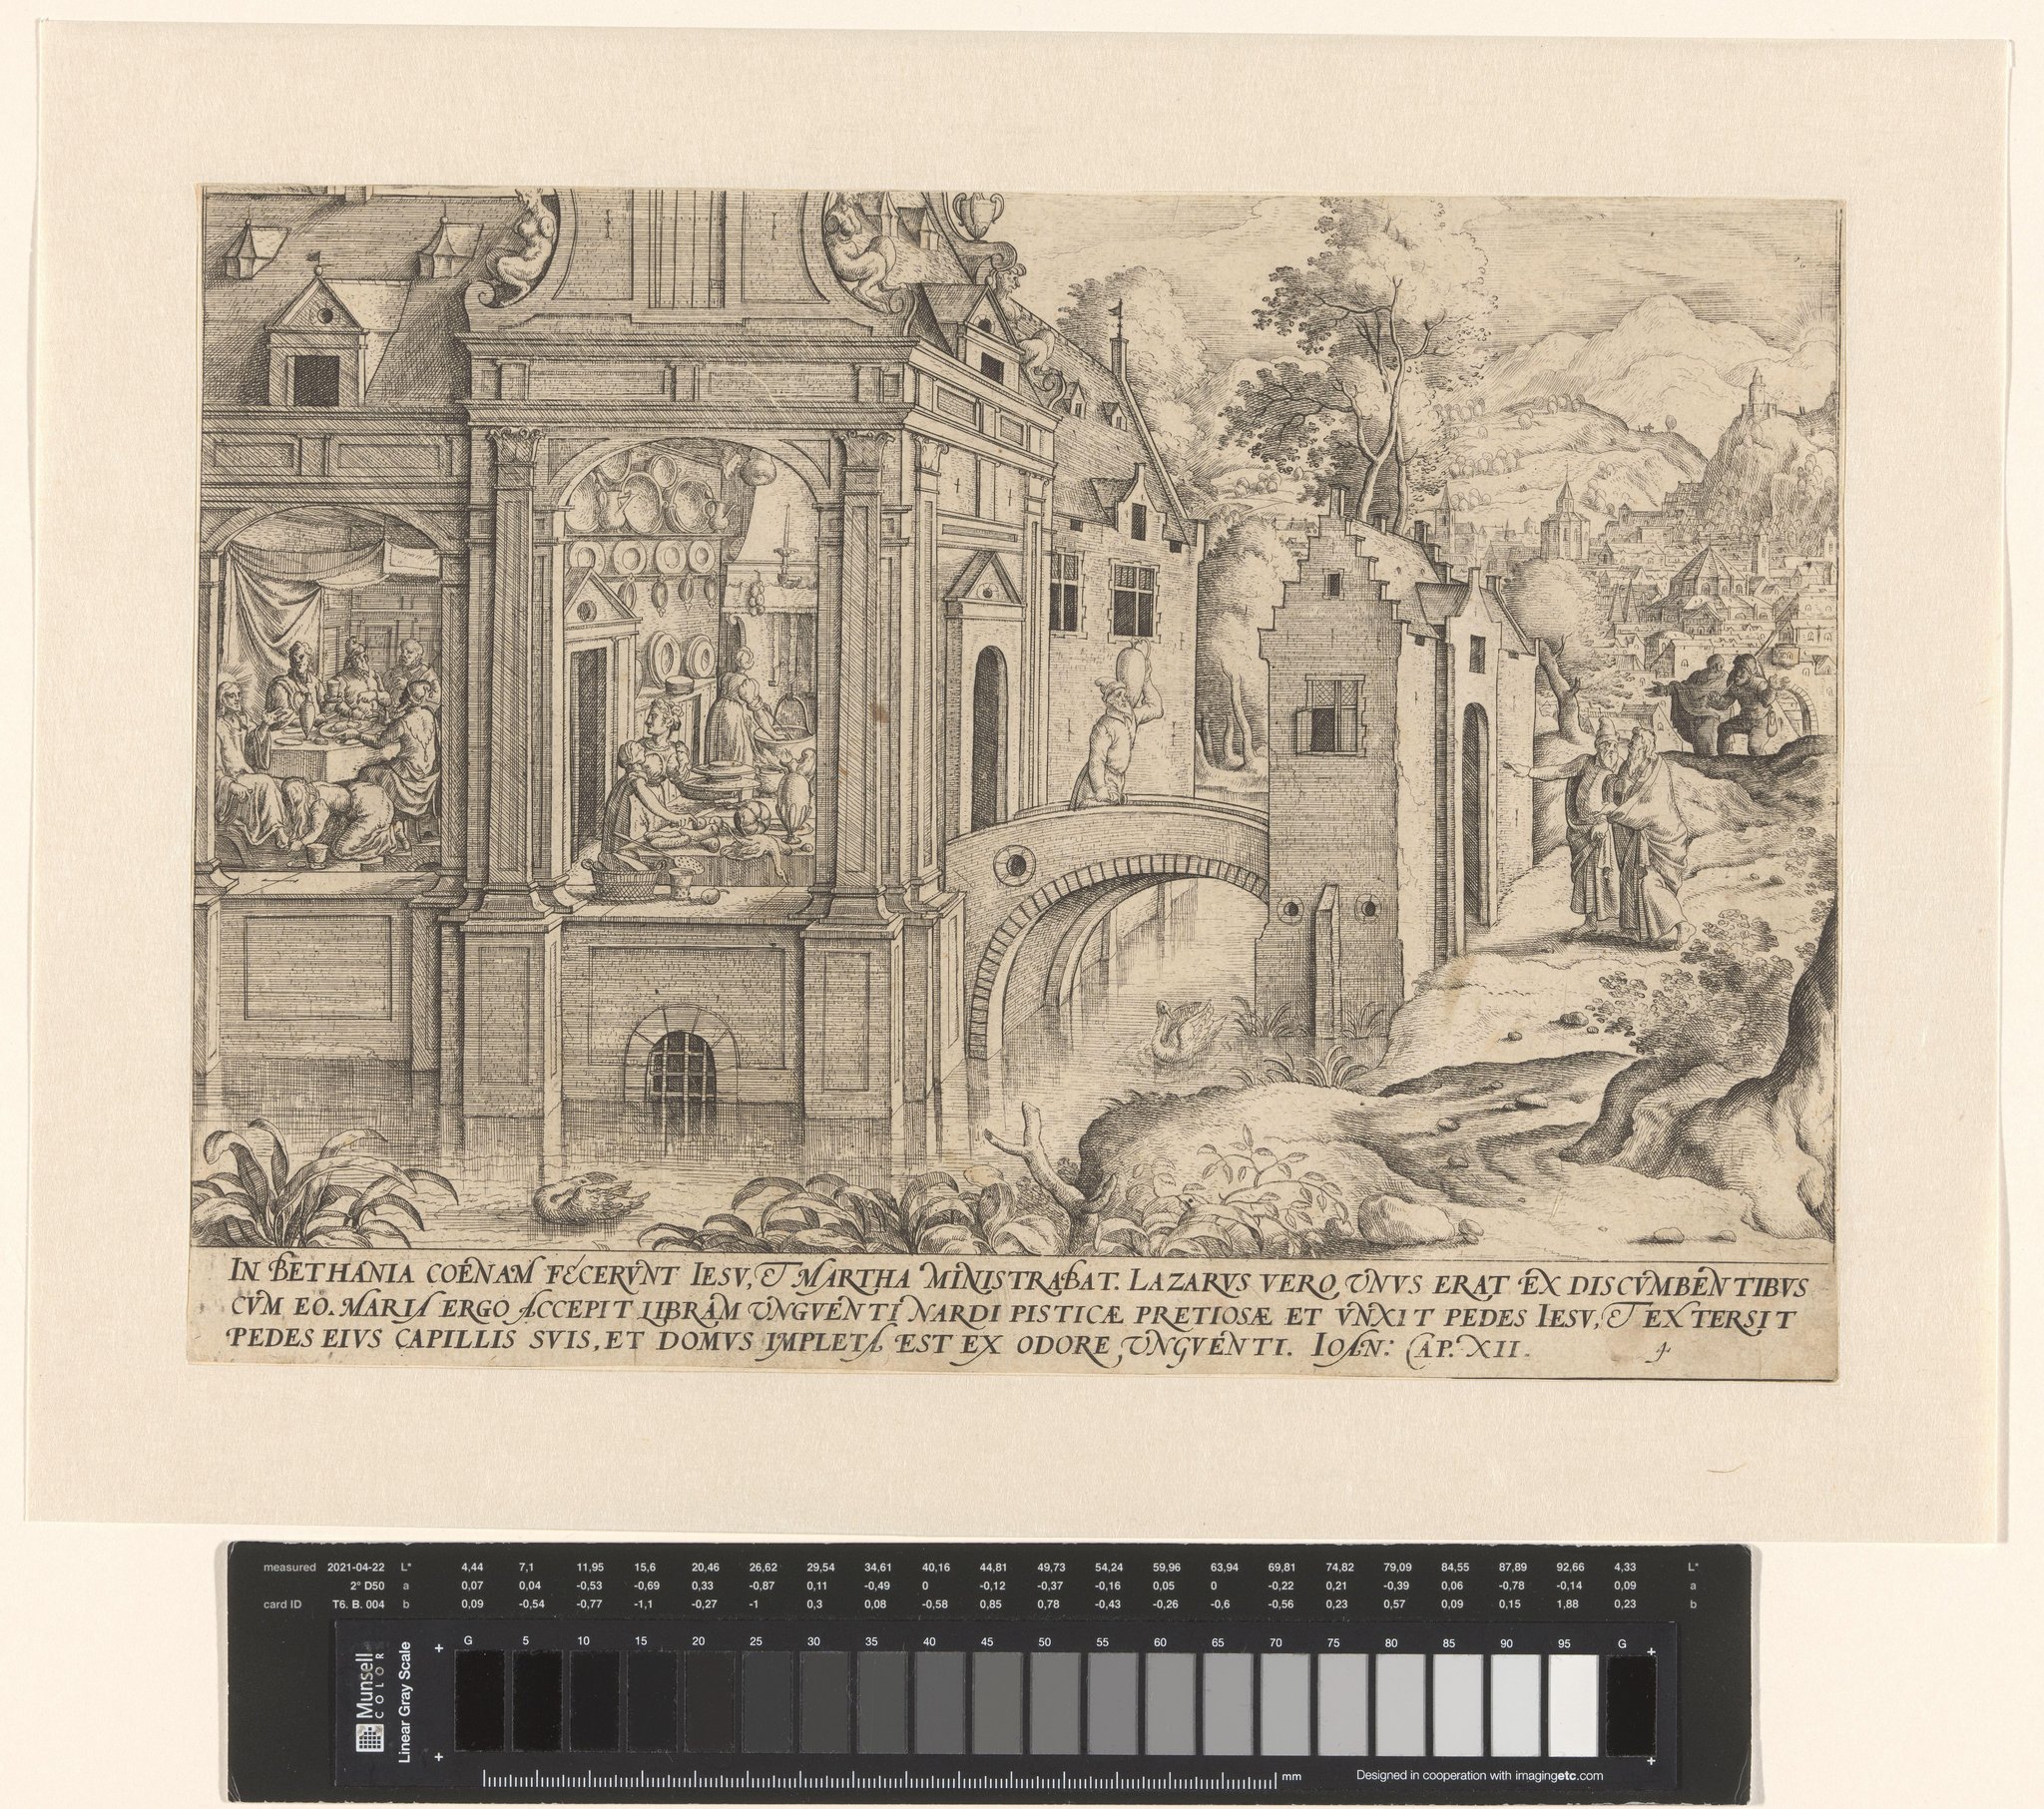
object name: print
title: Het banket te Bethanië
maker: hans bol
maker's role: draughtsman, print maker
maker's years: 1534-1593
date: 1580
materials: ink, paper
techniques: etching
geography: antwerp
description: De voortekeningen voor de reeks zijn gedateerd 1568; de etsen hiernaar maakte Hans Bol ruim tien jaar later in 1580 (zie datum op de derde prent uit de reeks). De voortekening voor deze ets bevindt zich in bij e Stichting P. & N. de Boer, Amsterdam. De prent is gemonteerd op de versozijde van een 17de-eeuws (?) albumblad met op de verso een tegendruk van een andere prent.